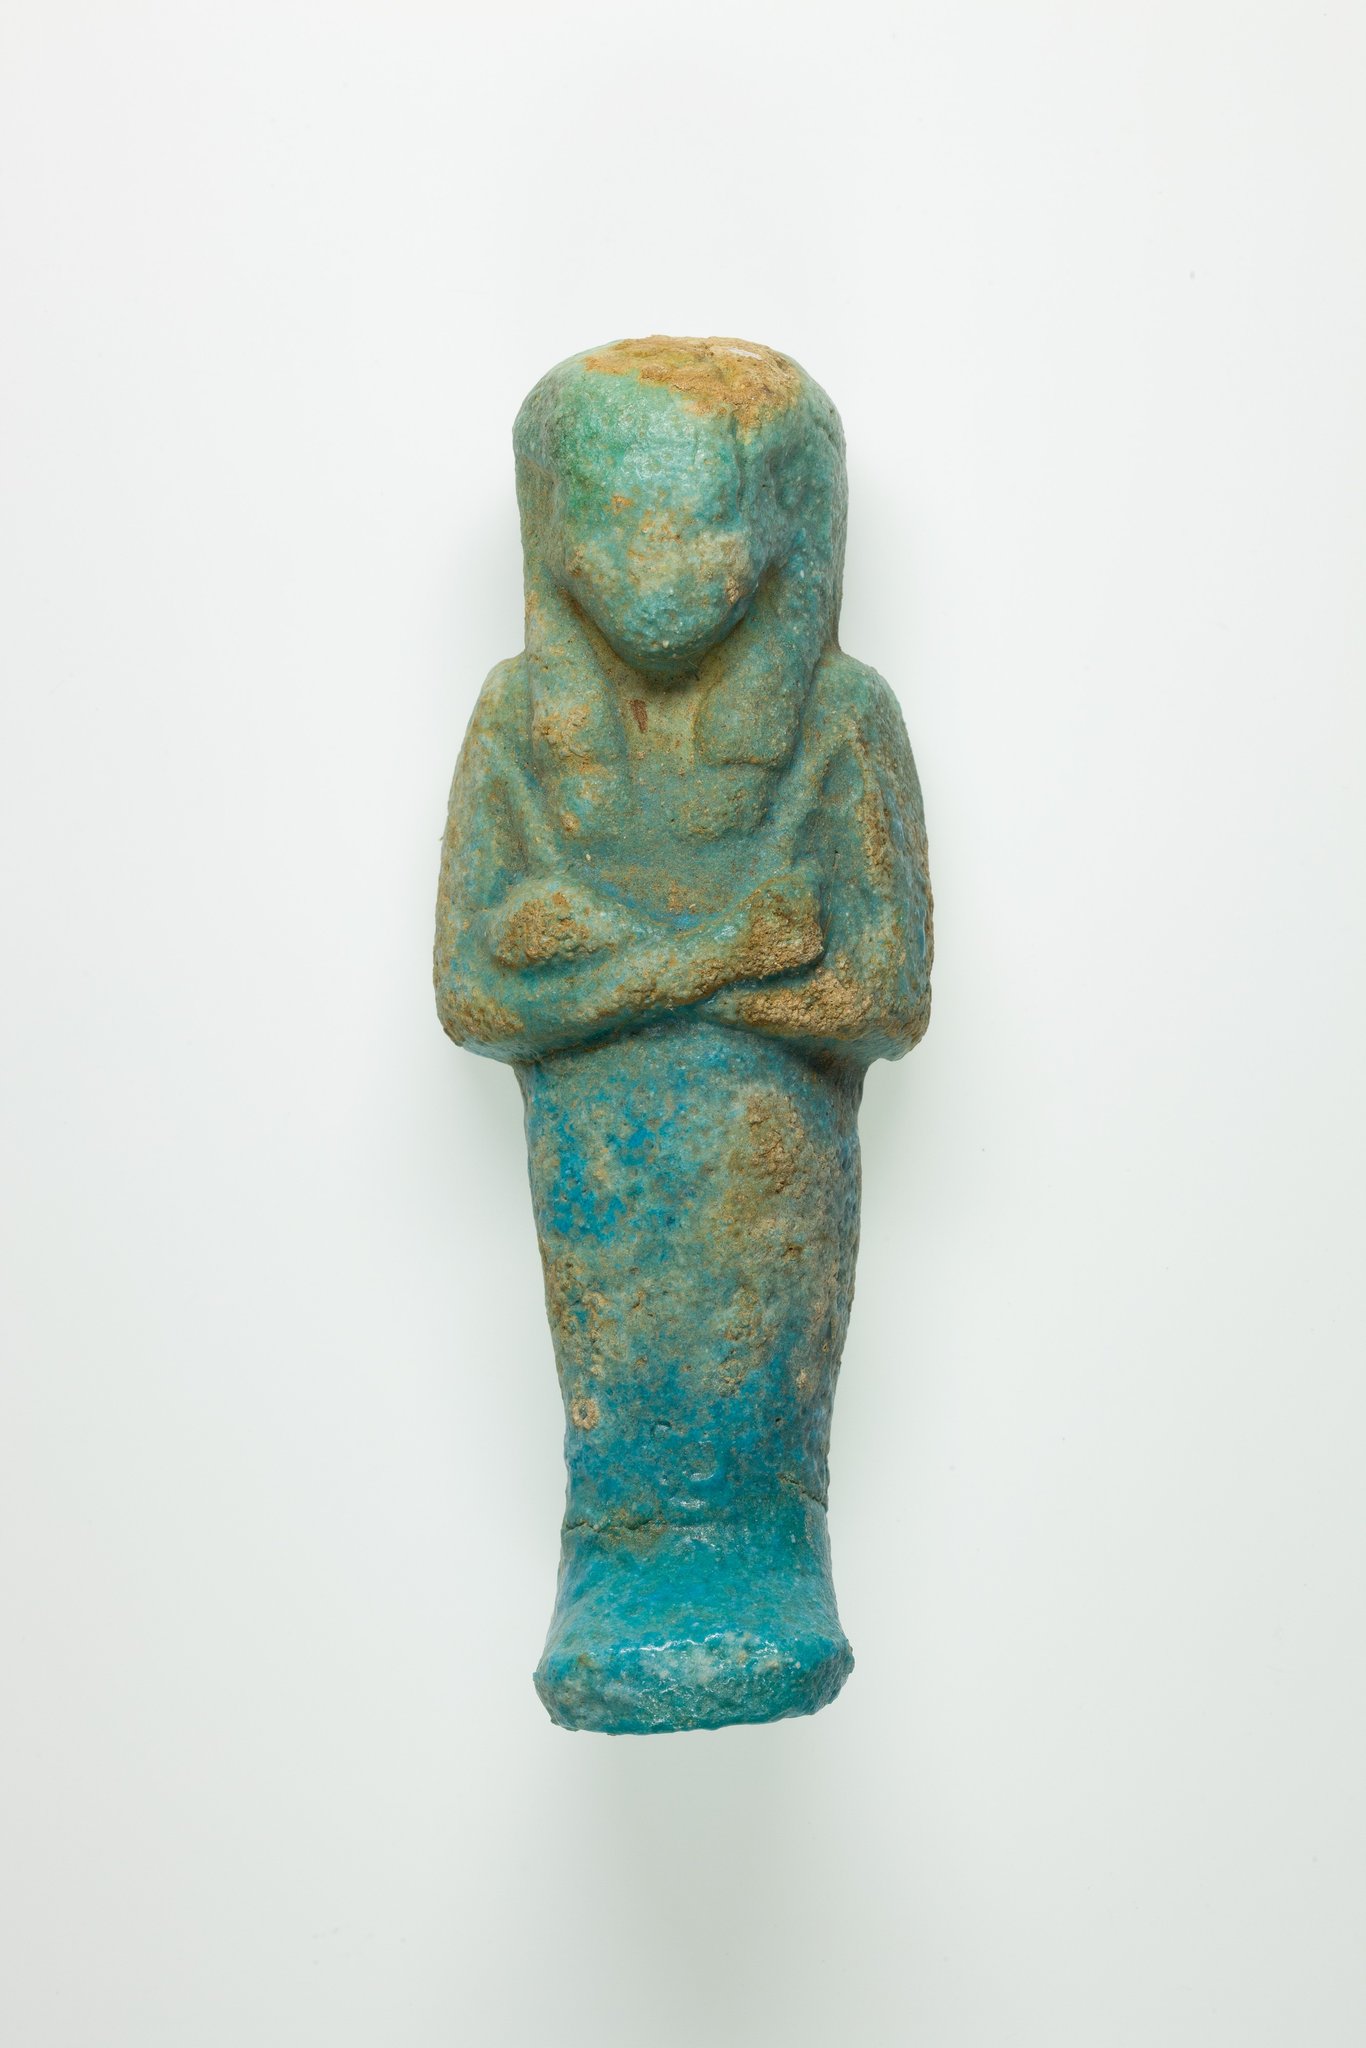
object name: worker shabti, henettawy c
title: Worker Shabti of Henettawy (C), Daughter of Isetemkheb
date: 990-970 BCE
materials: faience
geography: egypt